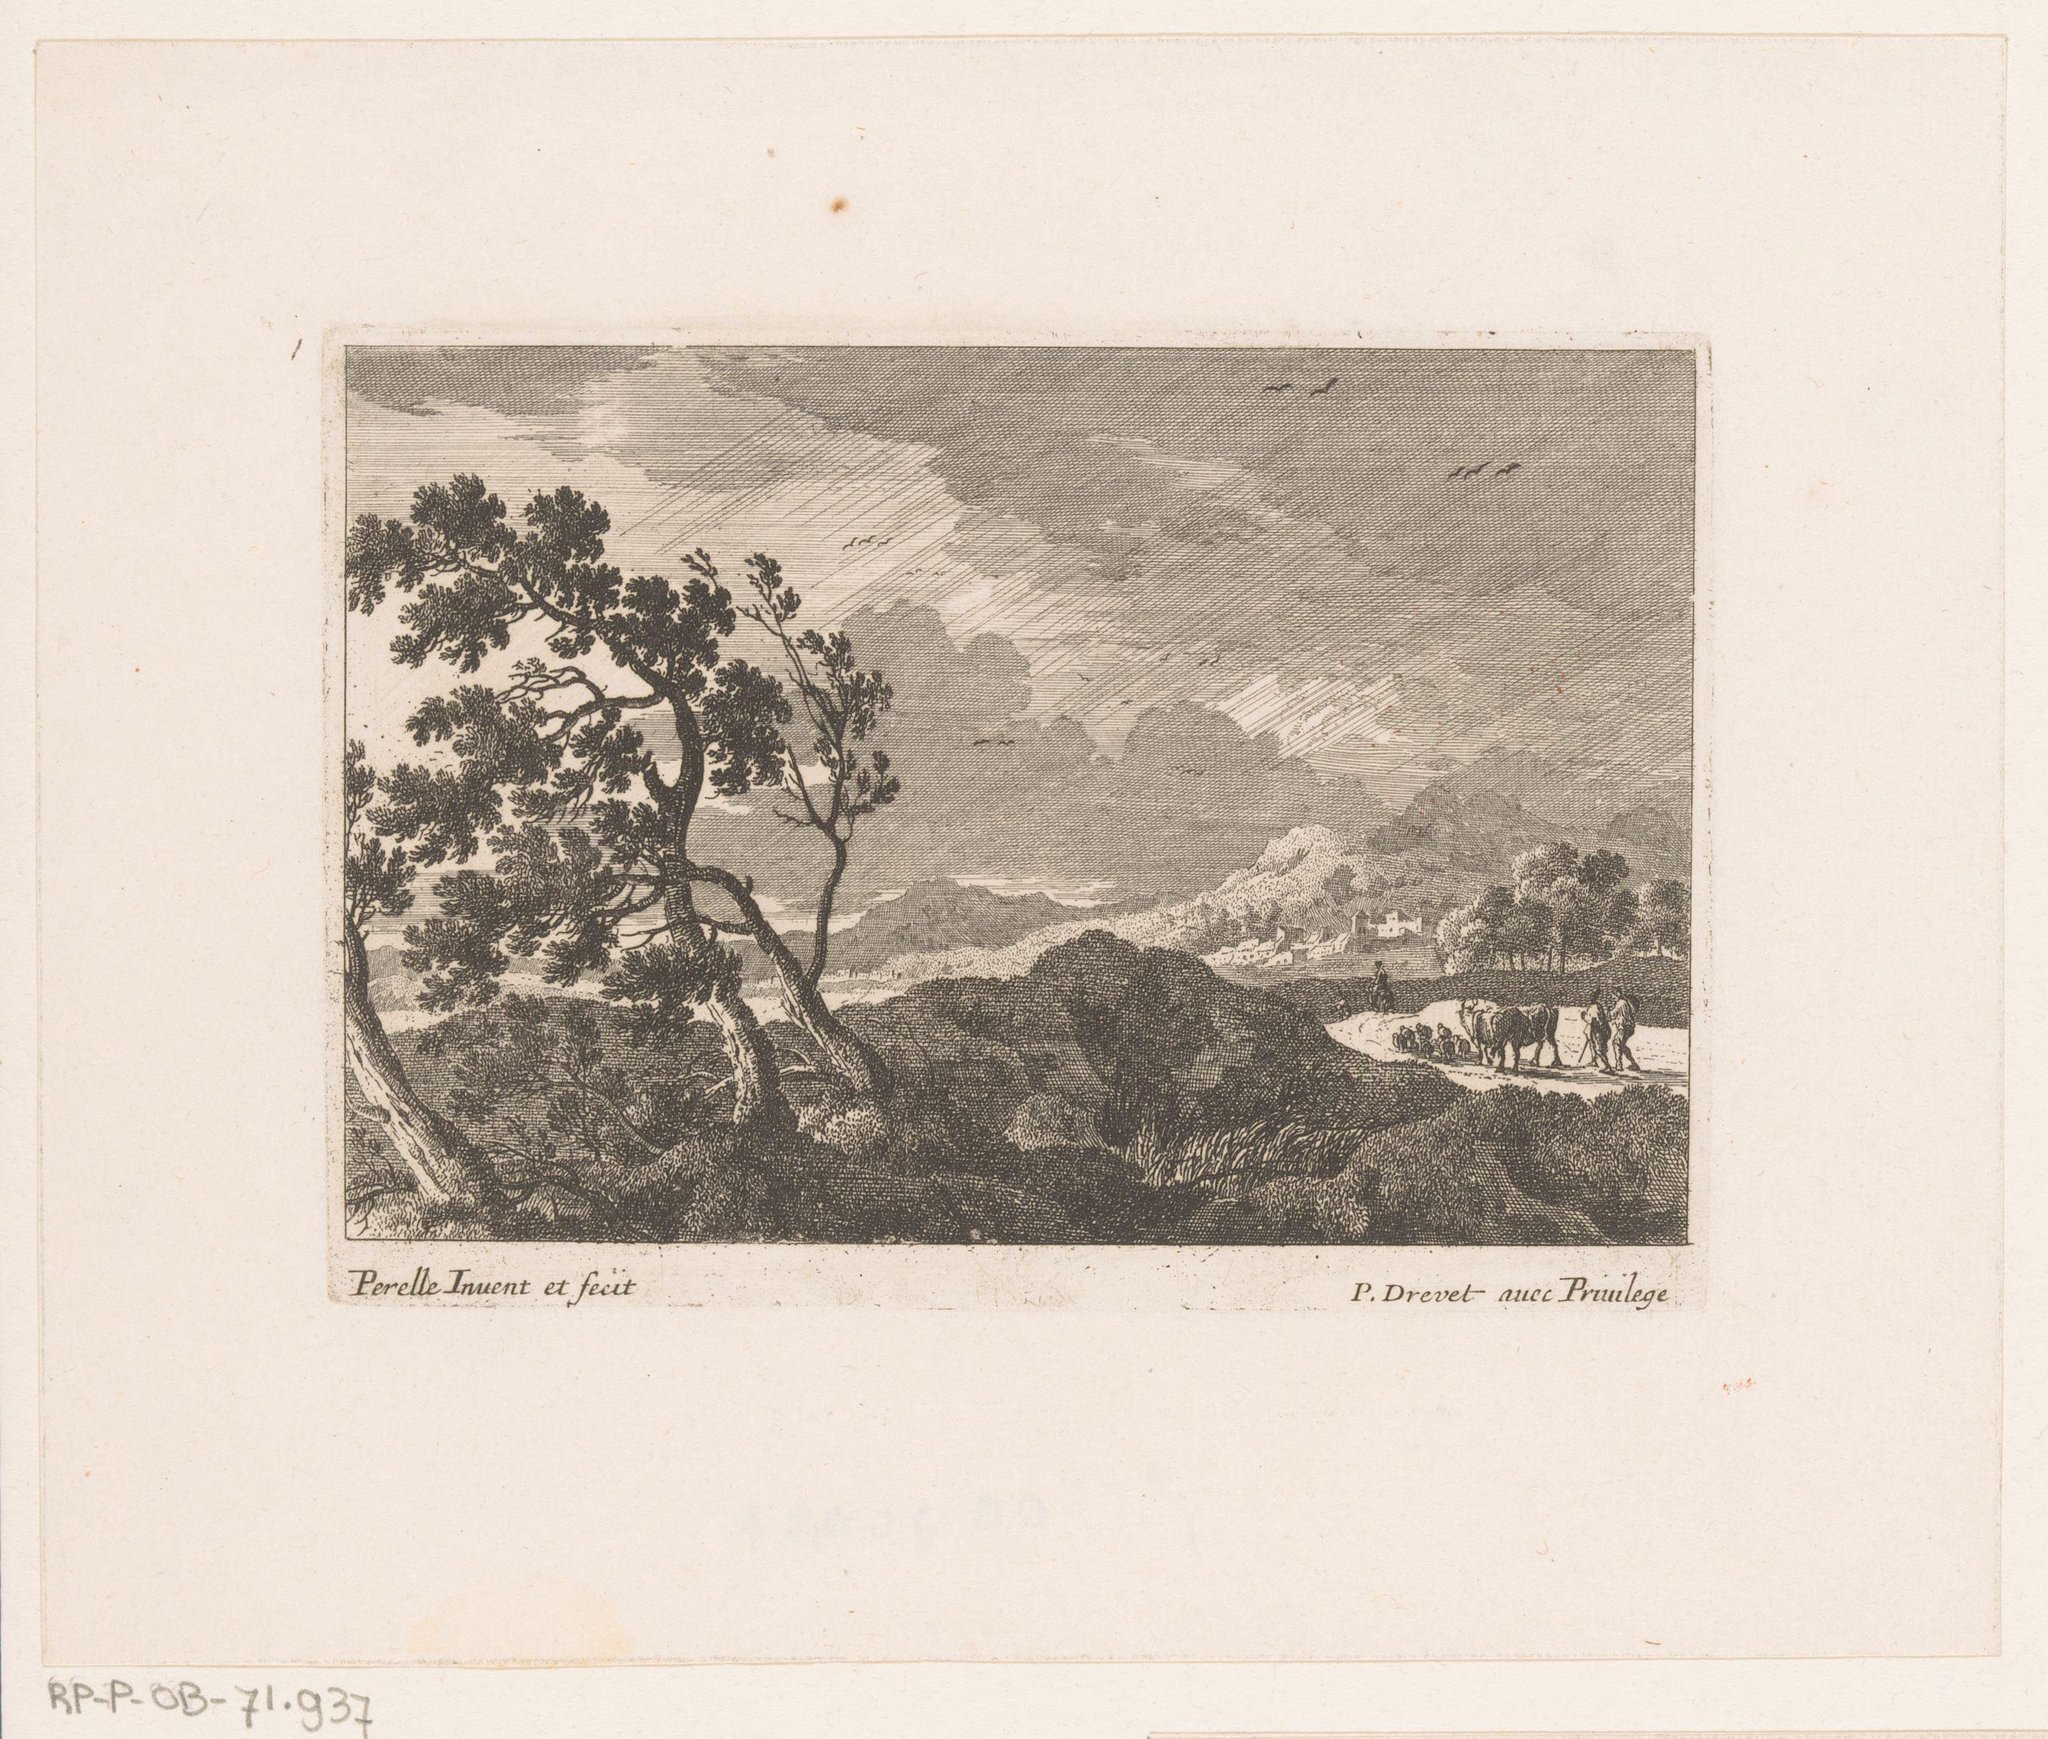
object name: print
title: Landschap met herders in storm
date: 1673-1695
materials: paper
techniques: etching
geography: paris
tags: landscapes, herding, herdsman, herdswoman, shepherd, shepherdess, cowherd, etc., storm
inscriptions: collector's mark: Lugt 240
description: Prenten met het signatuur 'Perelle' kunnen zowel door vader Gabriel als door zonen Nicolas en Adam gemaakt zijn.